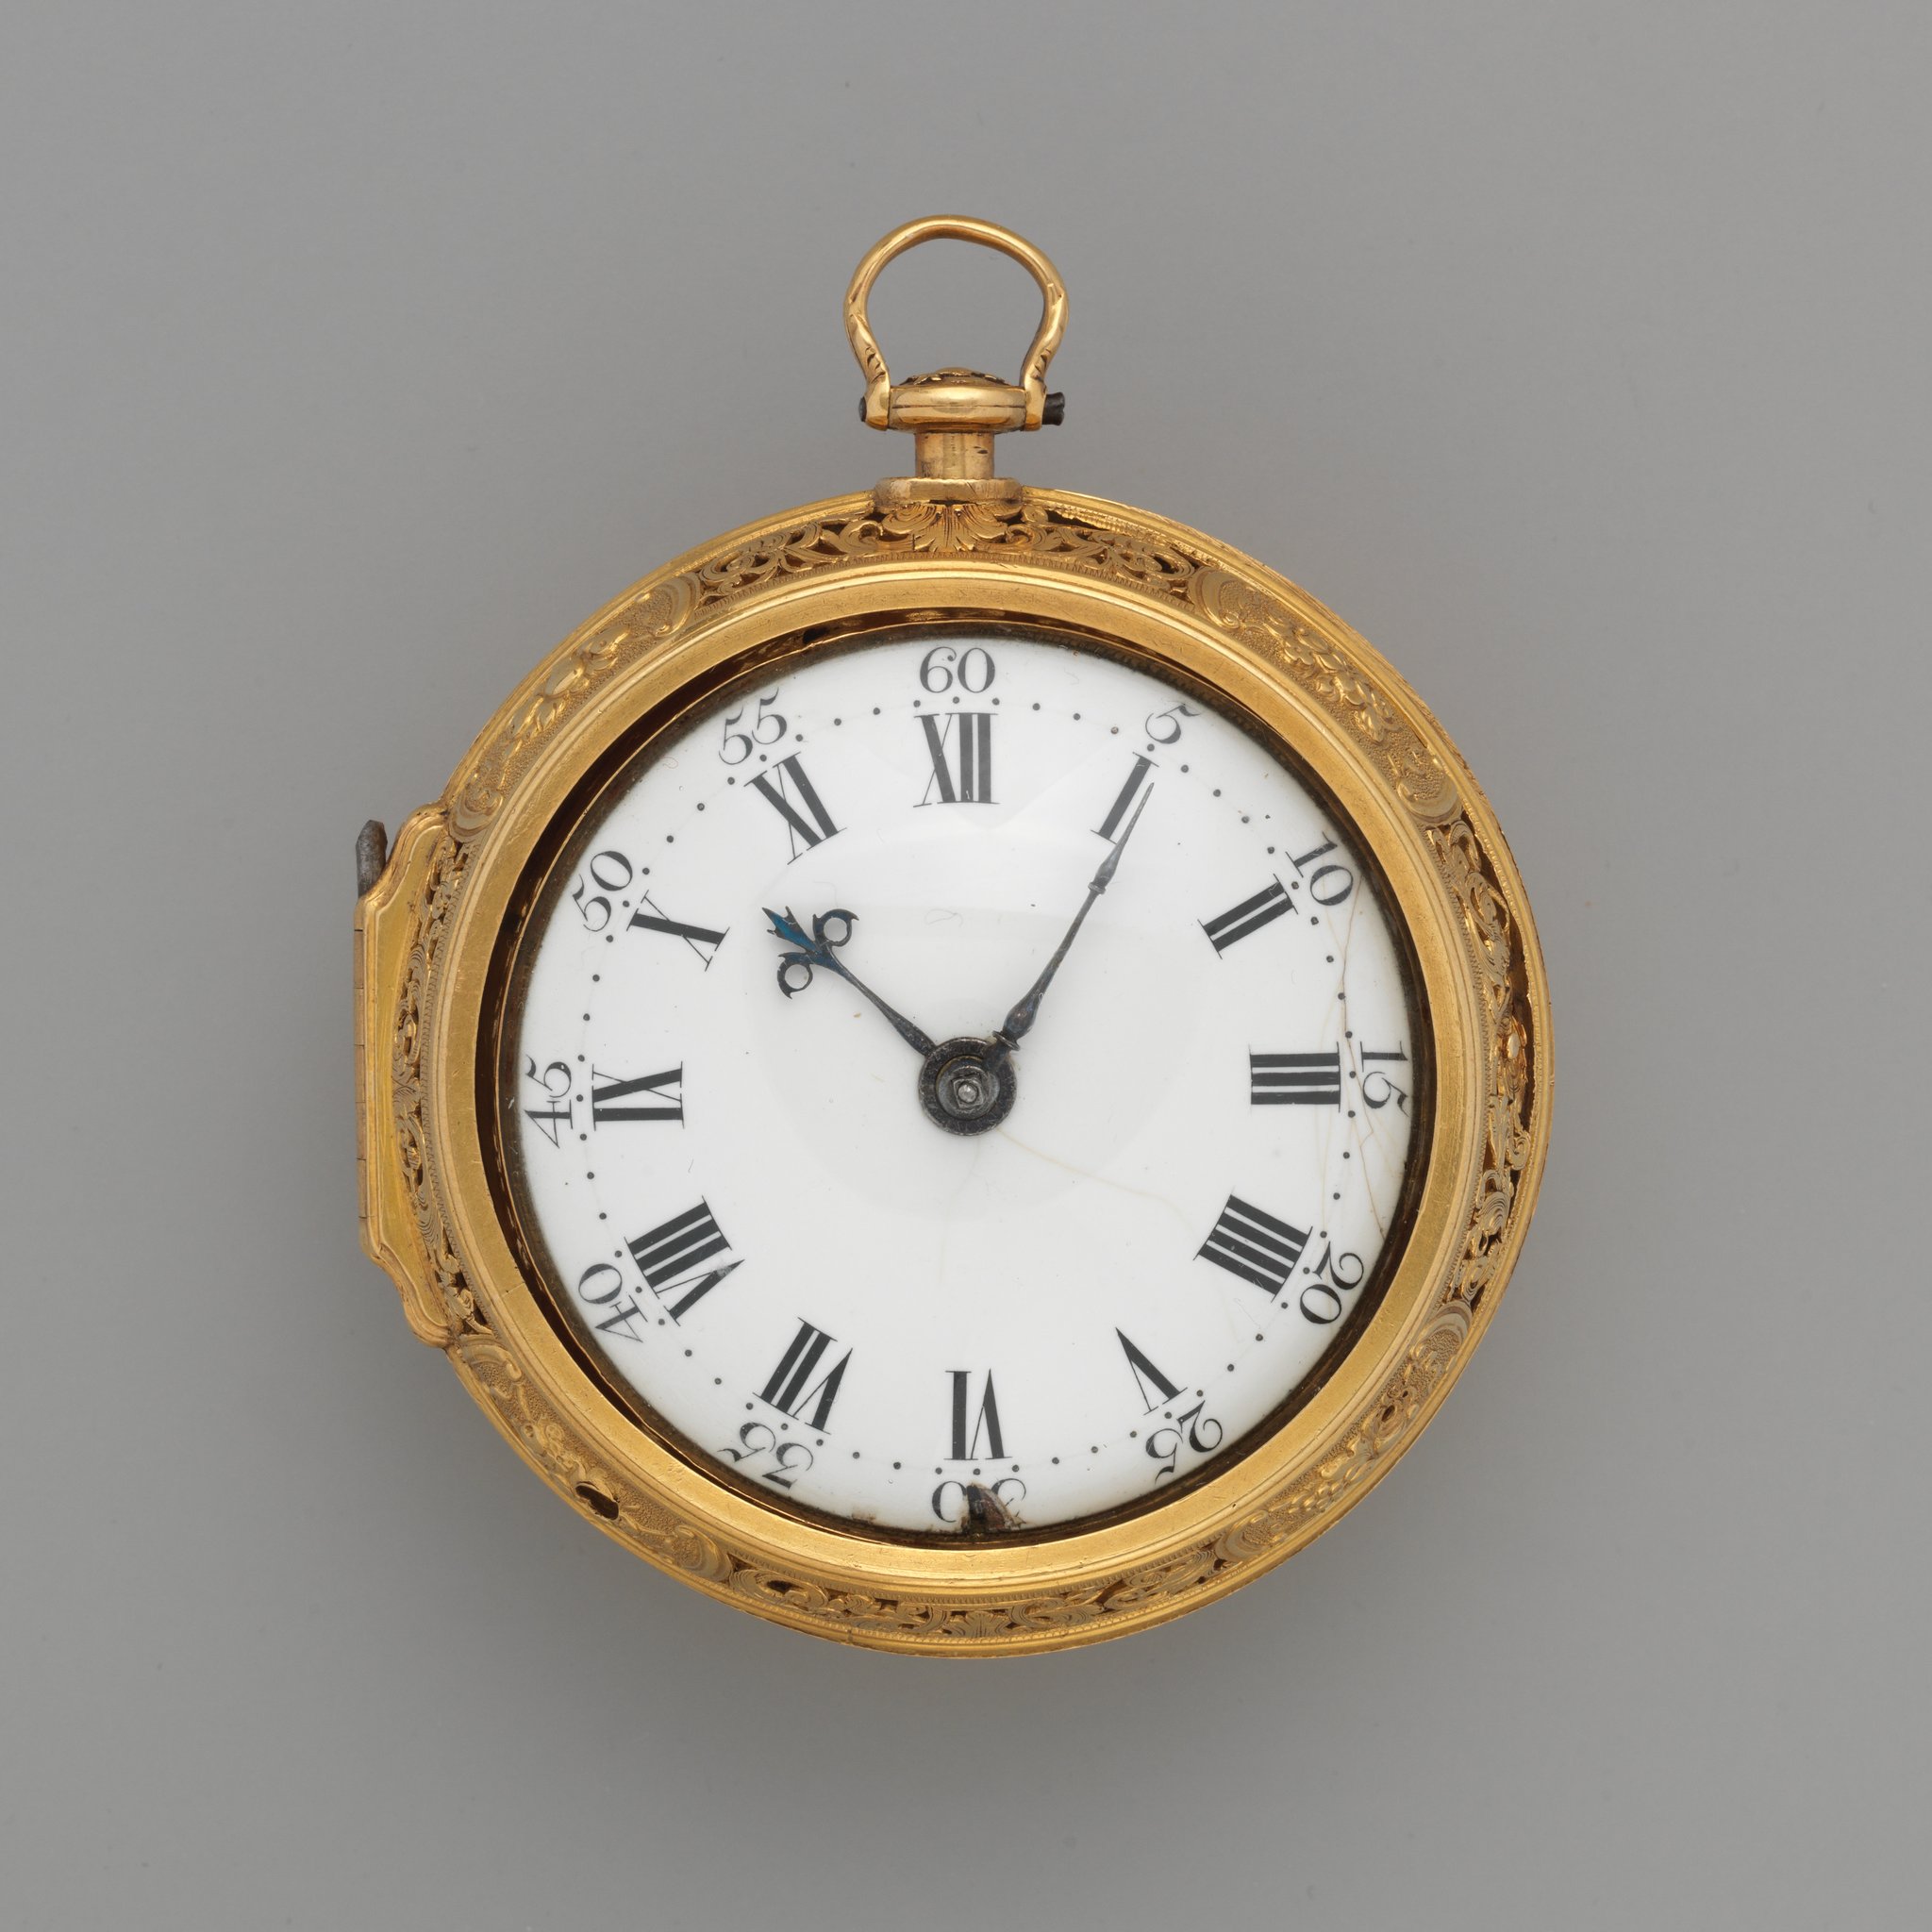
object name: watch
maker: william webster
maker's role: maker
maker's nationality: british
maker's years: 1635-1735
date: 1720-1730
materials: enamel, gold